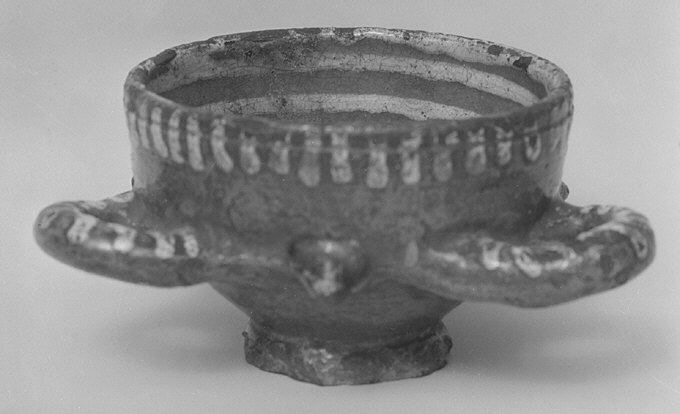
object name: cup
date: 1401-1600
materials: earthenware